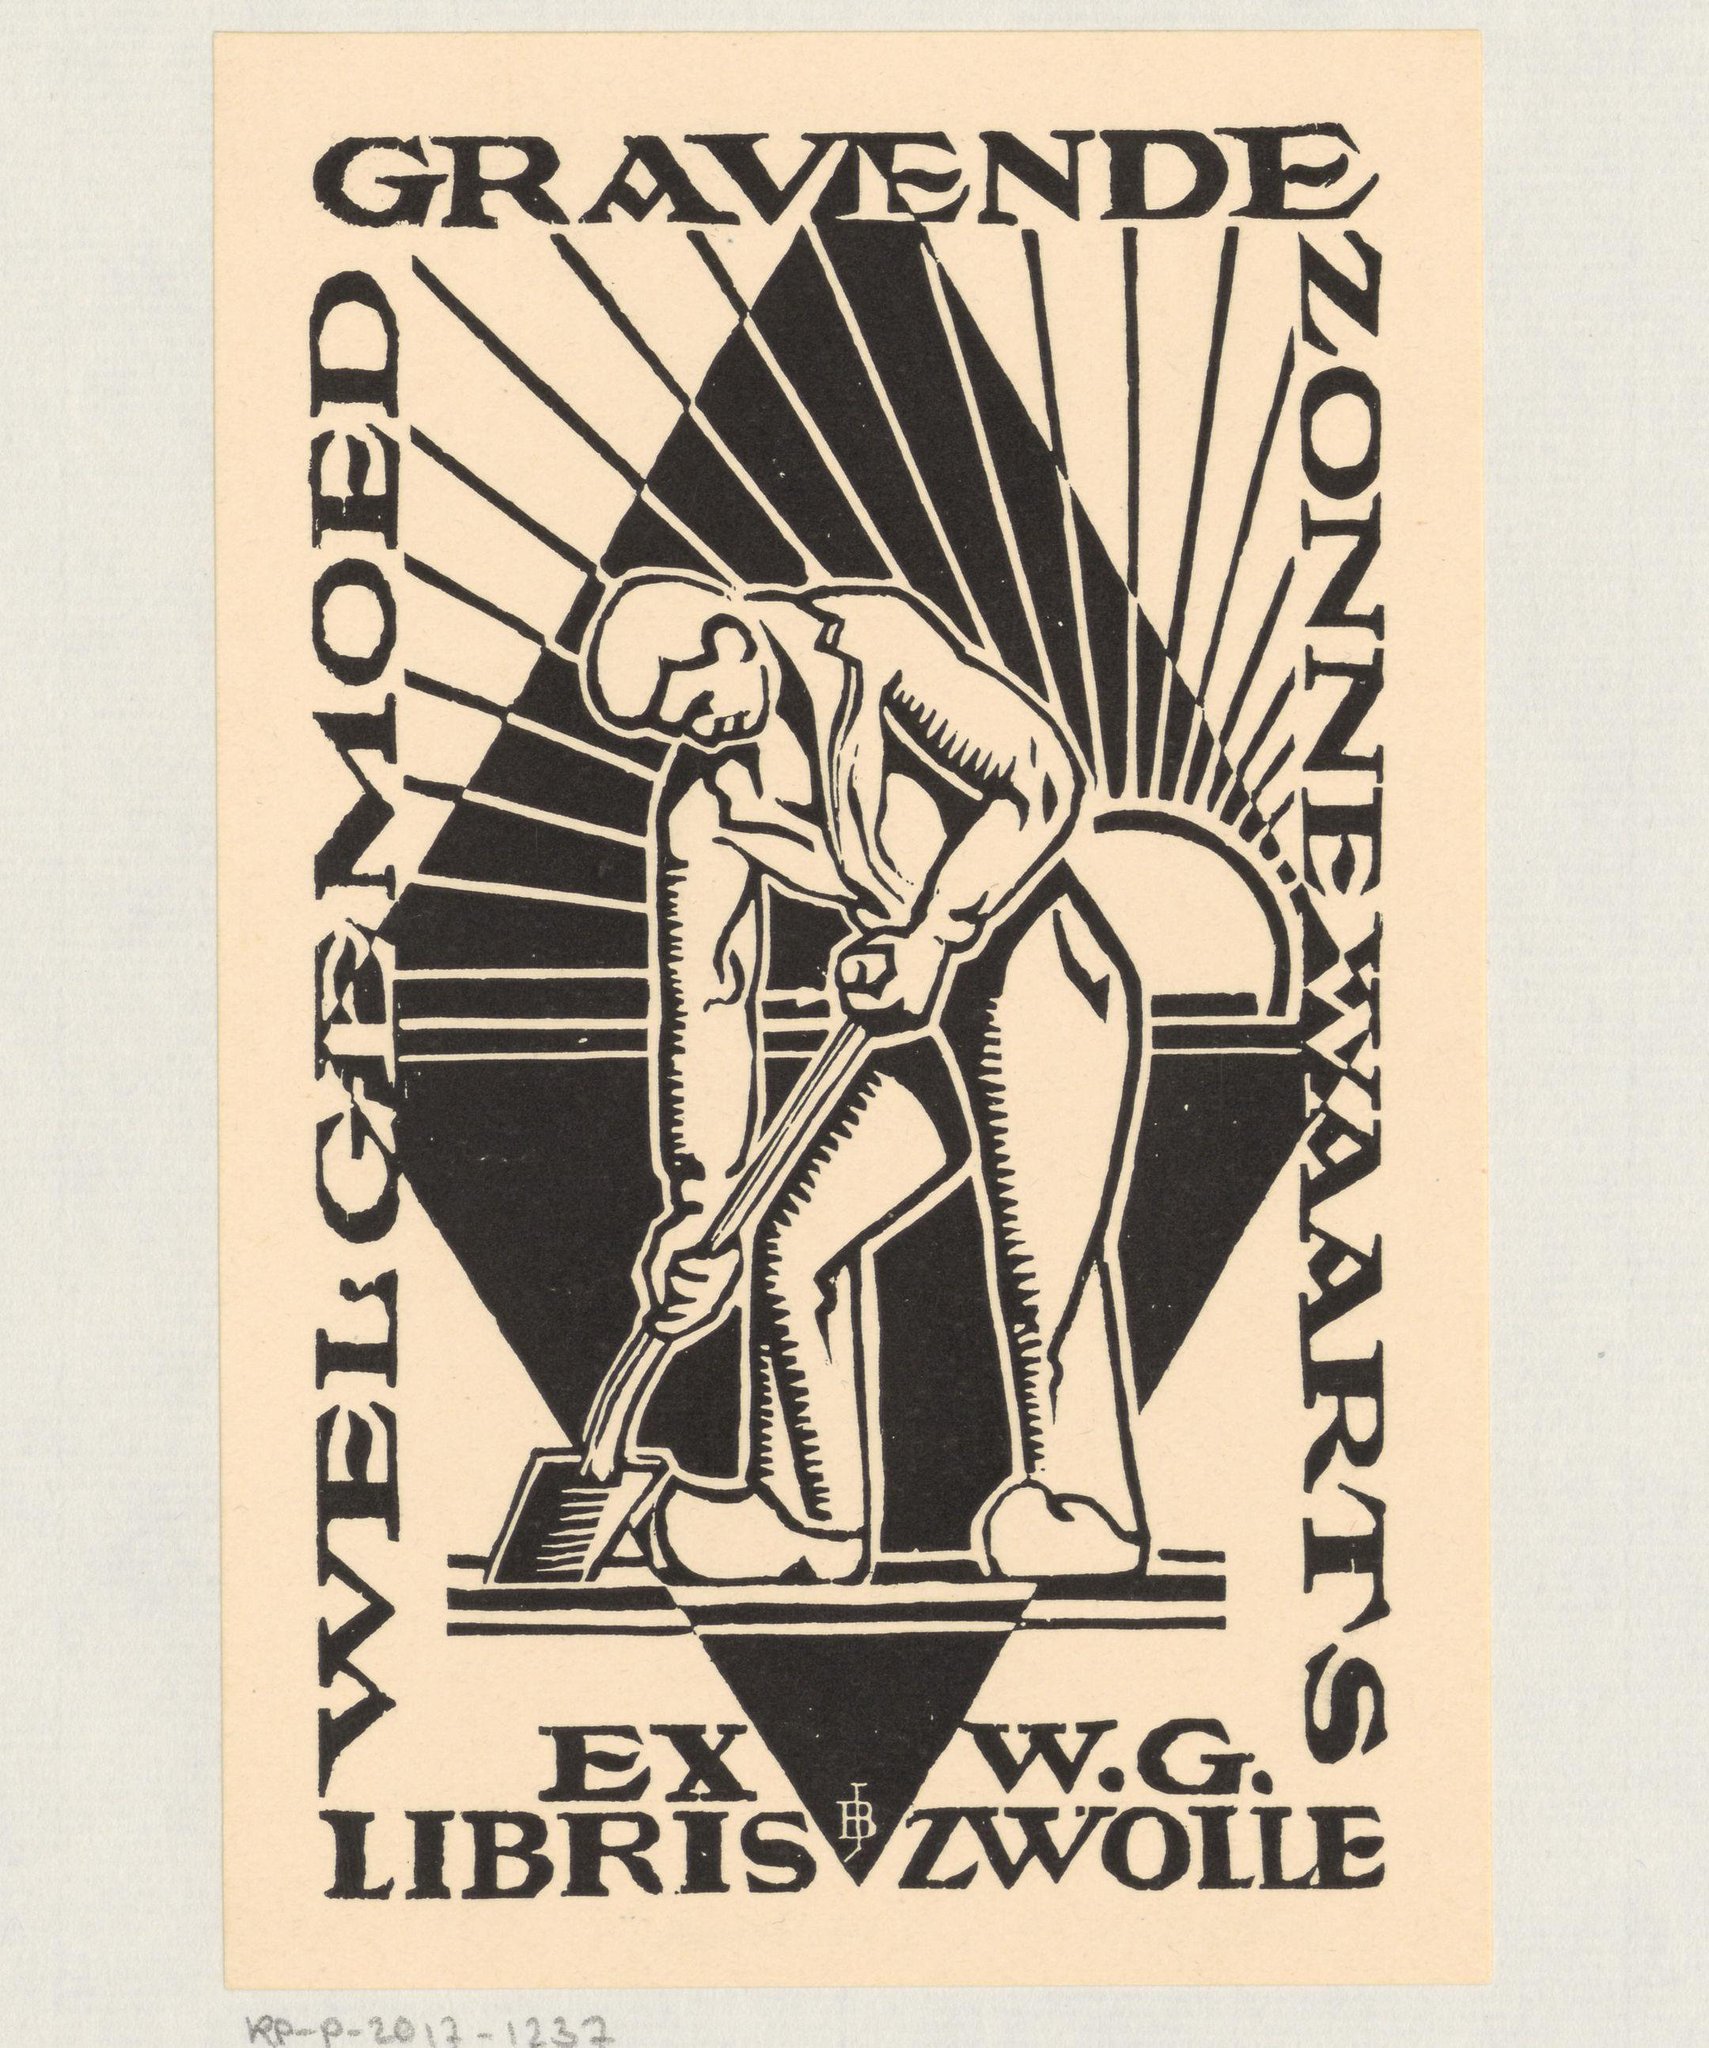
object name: bookplate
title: Ex libris van W.G. Zwolle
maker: j. van bakkum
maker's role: print maker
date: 1938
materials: paper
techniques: woodcut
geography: netherlands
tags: farmers, sunrise, spading ~ soil cultivation